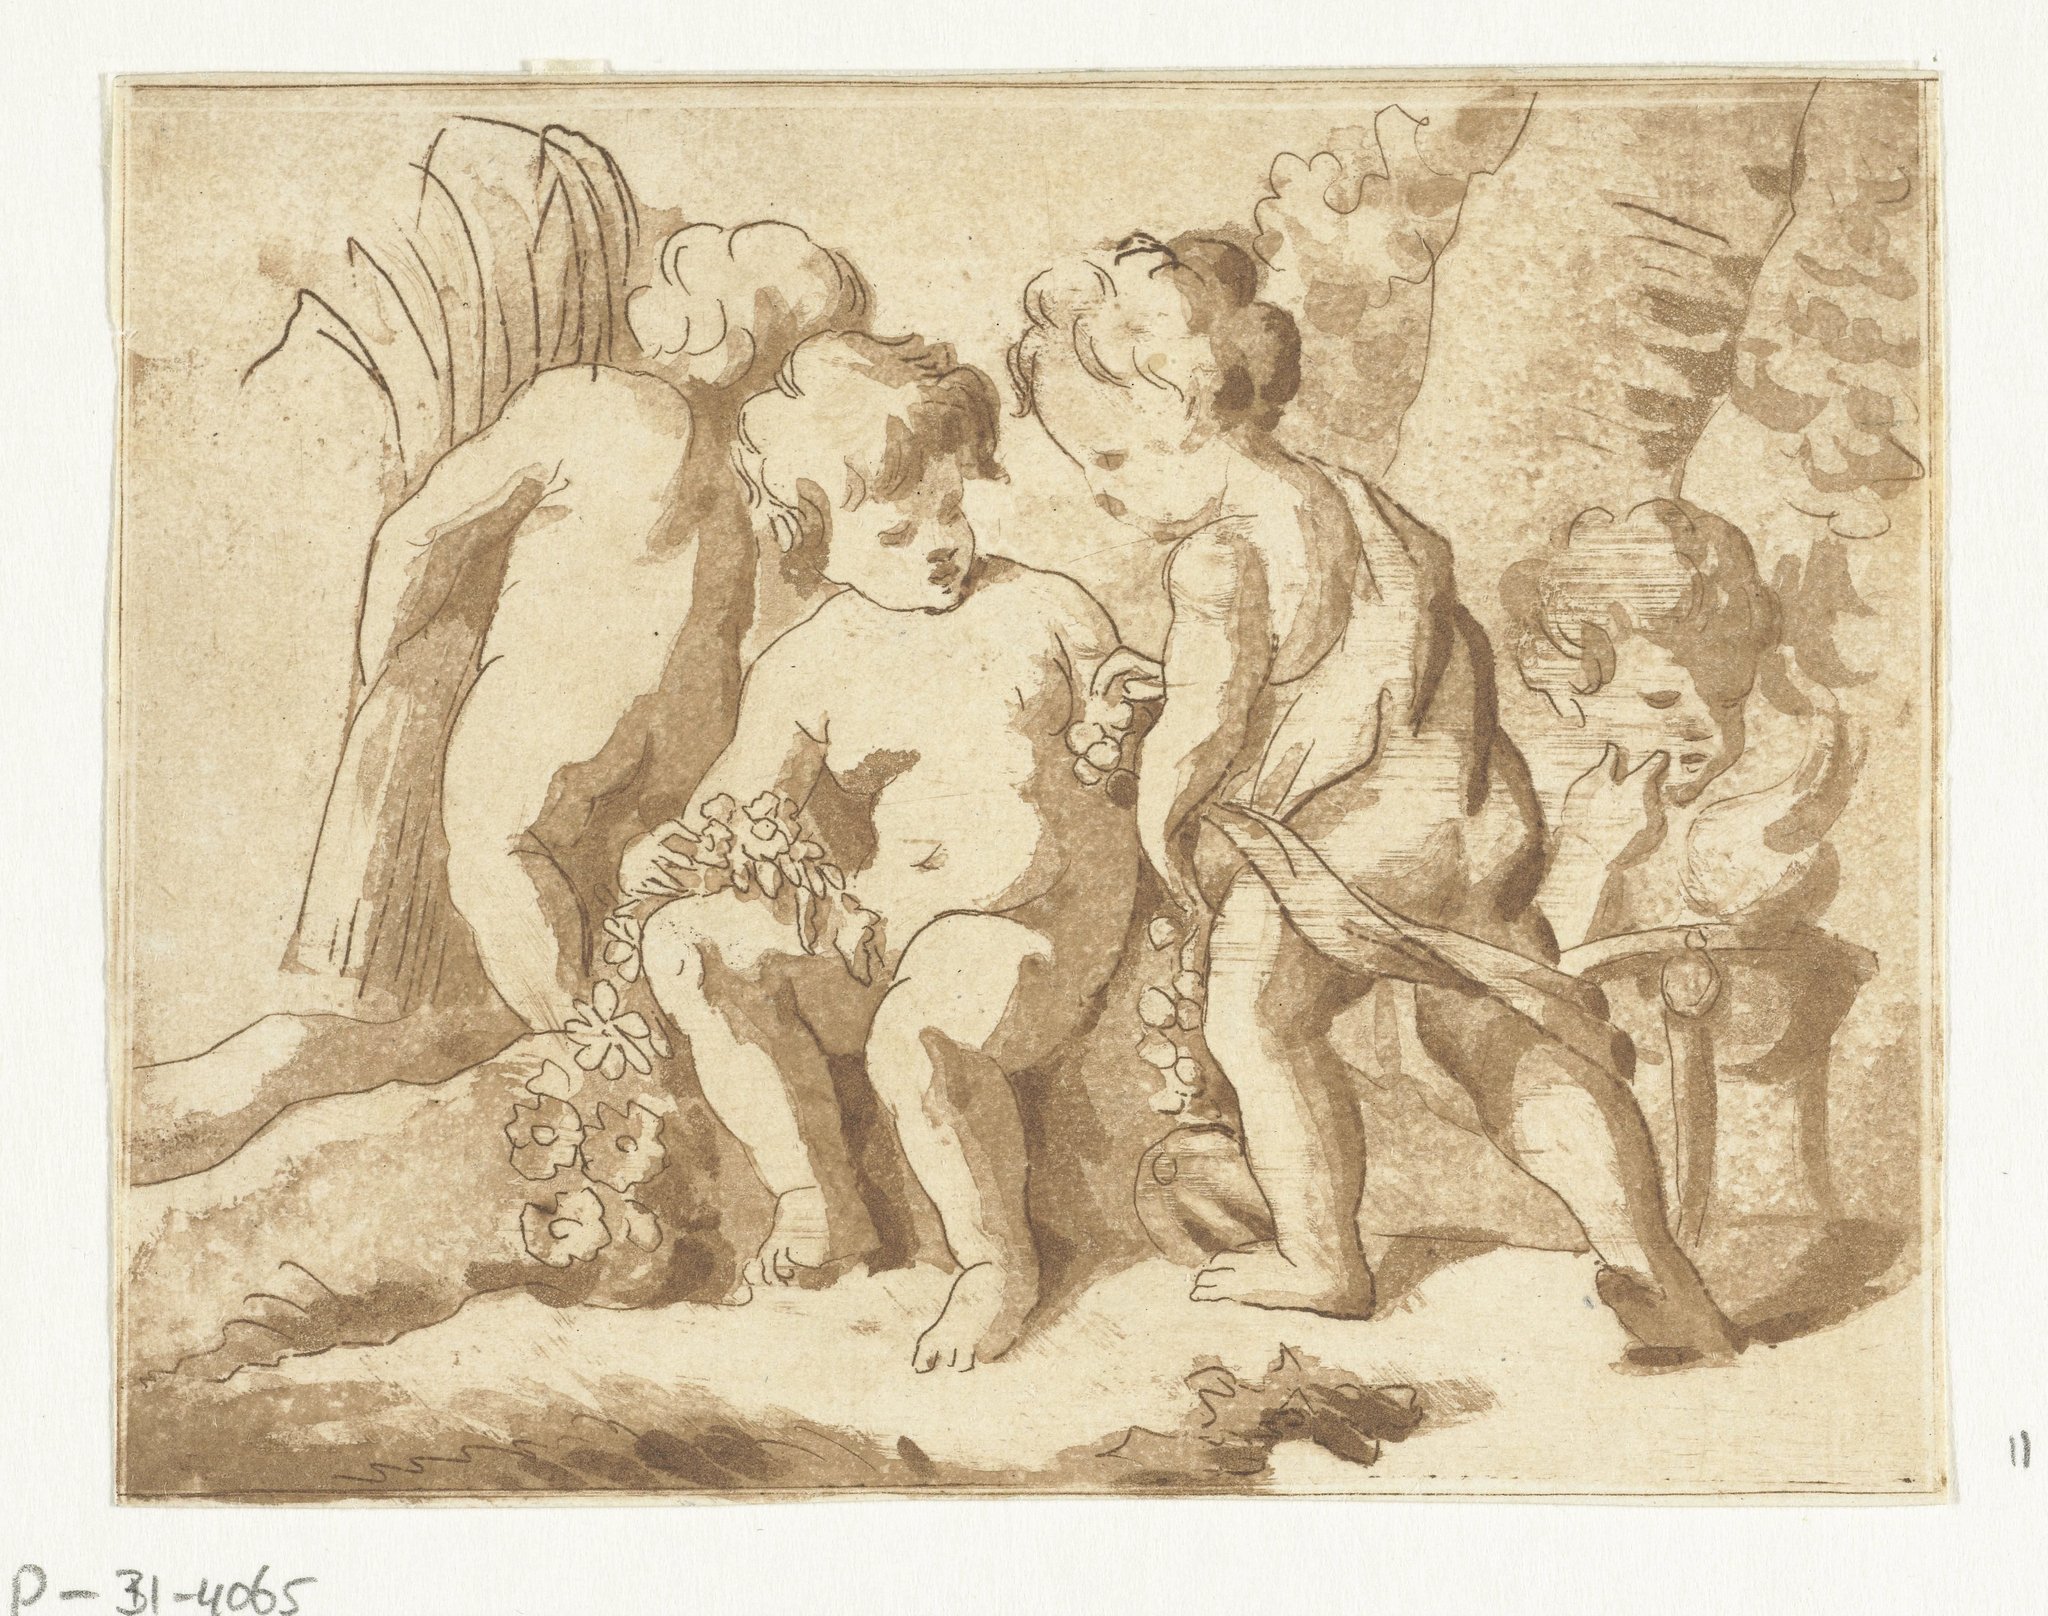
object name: print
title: Vier seizoenen voorgesteld door vier kinderen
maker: anthonie van den bos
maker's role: draughtsman, print maker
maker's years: 1763-1838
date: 1778-1838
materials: paper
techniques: aquatint, etching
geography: netherlands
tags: seasons of the year (esp. personifications); 'stagione', 'le quattro stagione dell'anno' (ripa), seasons of the year represented by scenes showing human activities, usually in a landscape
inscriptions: collector's mark: Lugt 2228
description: De Lente met bloemenkrans zit in het midden, linksachter de Zomer met korenschoof, rechts de Herfst die vruchten draagt en de Winter die zich warmt aan een vuur.